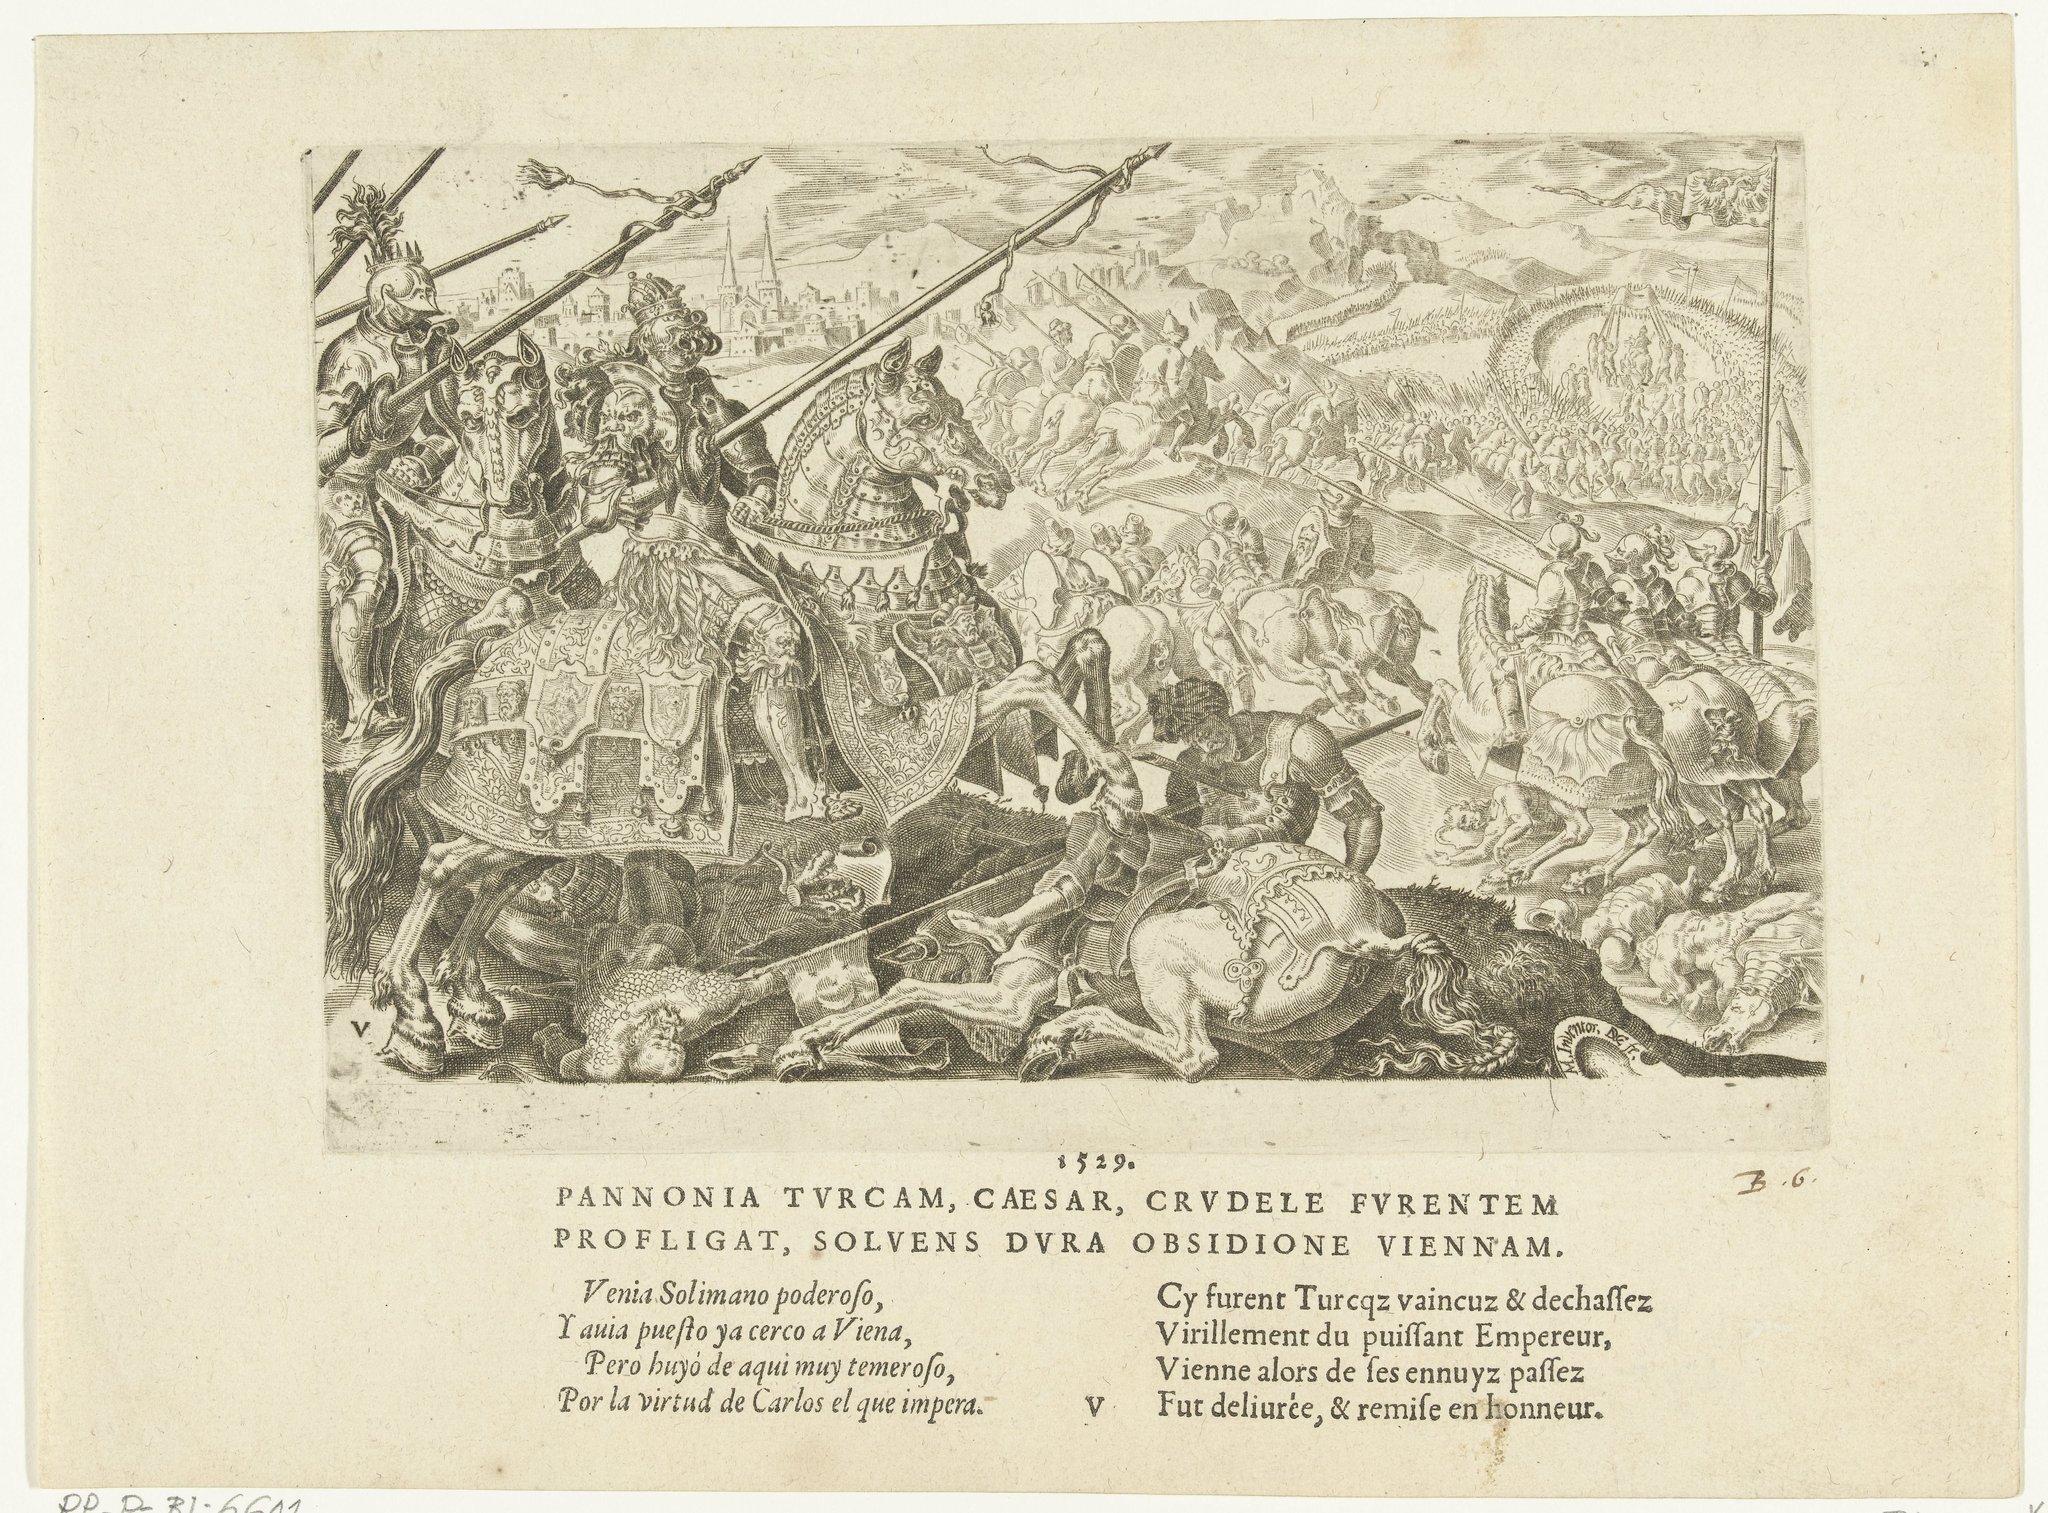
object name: history print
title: Triomfen van Karel V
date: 1555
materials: paper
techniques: engraving, etching, letterpress printing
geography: antwerp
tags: ghent, charles v (holy roman emperor and king of spain), battle, fighting in general, vienna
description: Ontzet van Wenen. De legers van Karel V dwingen de Turken onder leiding van sultan Süleyman I de Grote het beleg van Wenen op te geven, 1529. Ridders met pieken te paard. Onderschriften in twee regels Latijn, vier regels Spaans en vier regels Frans.